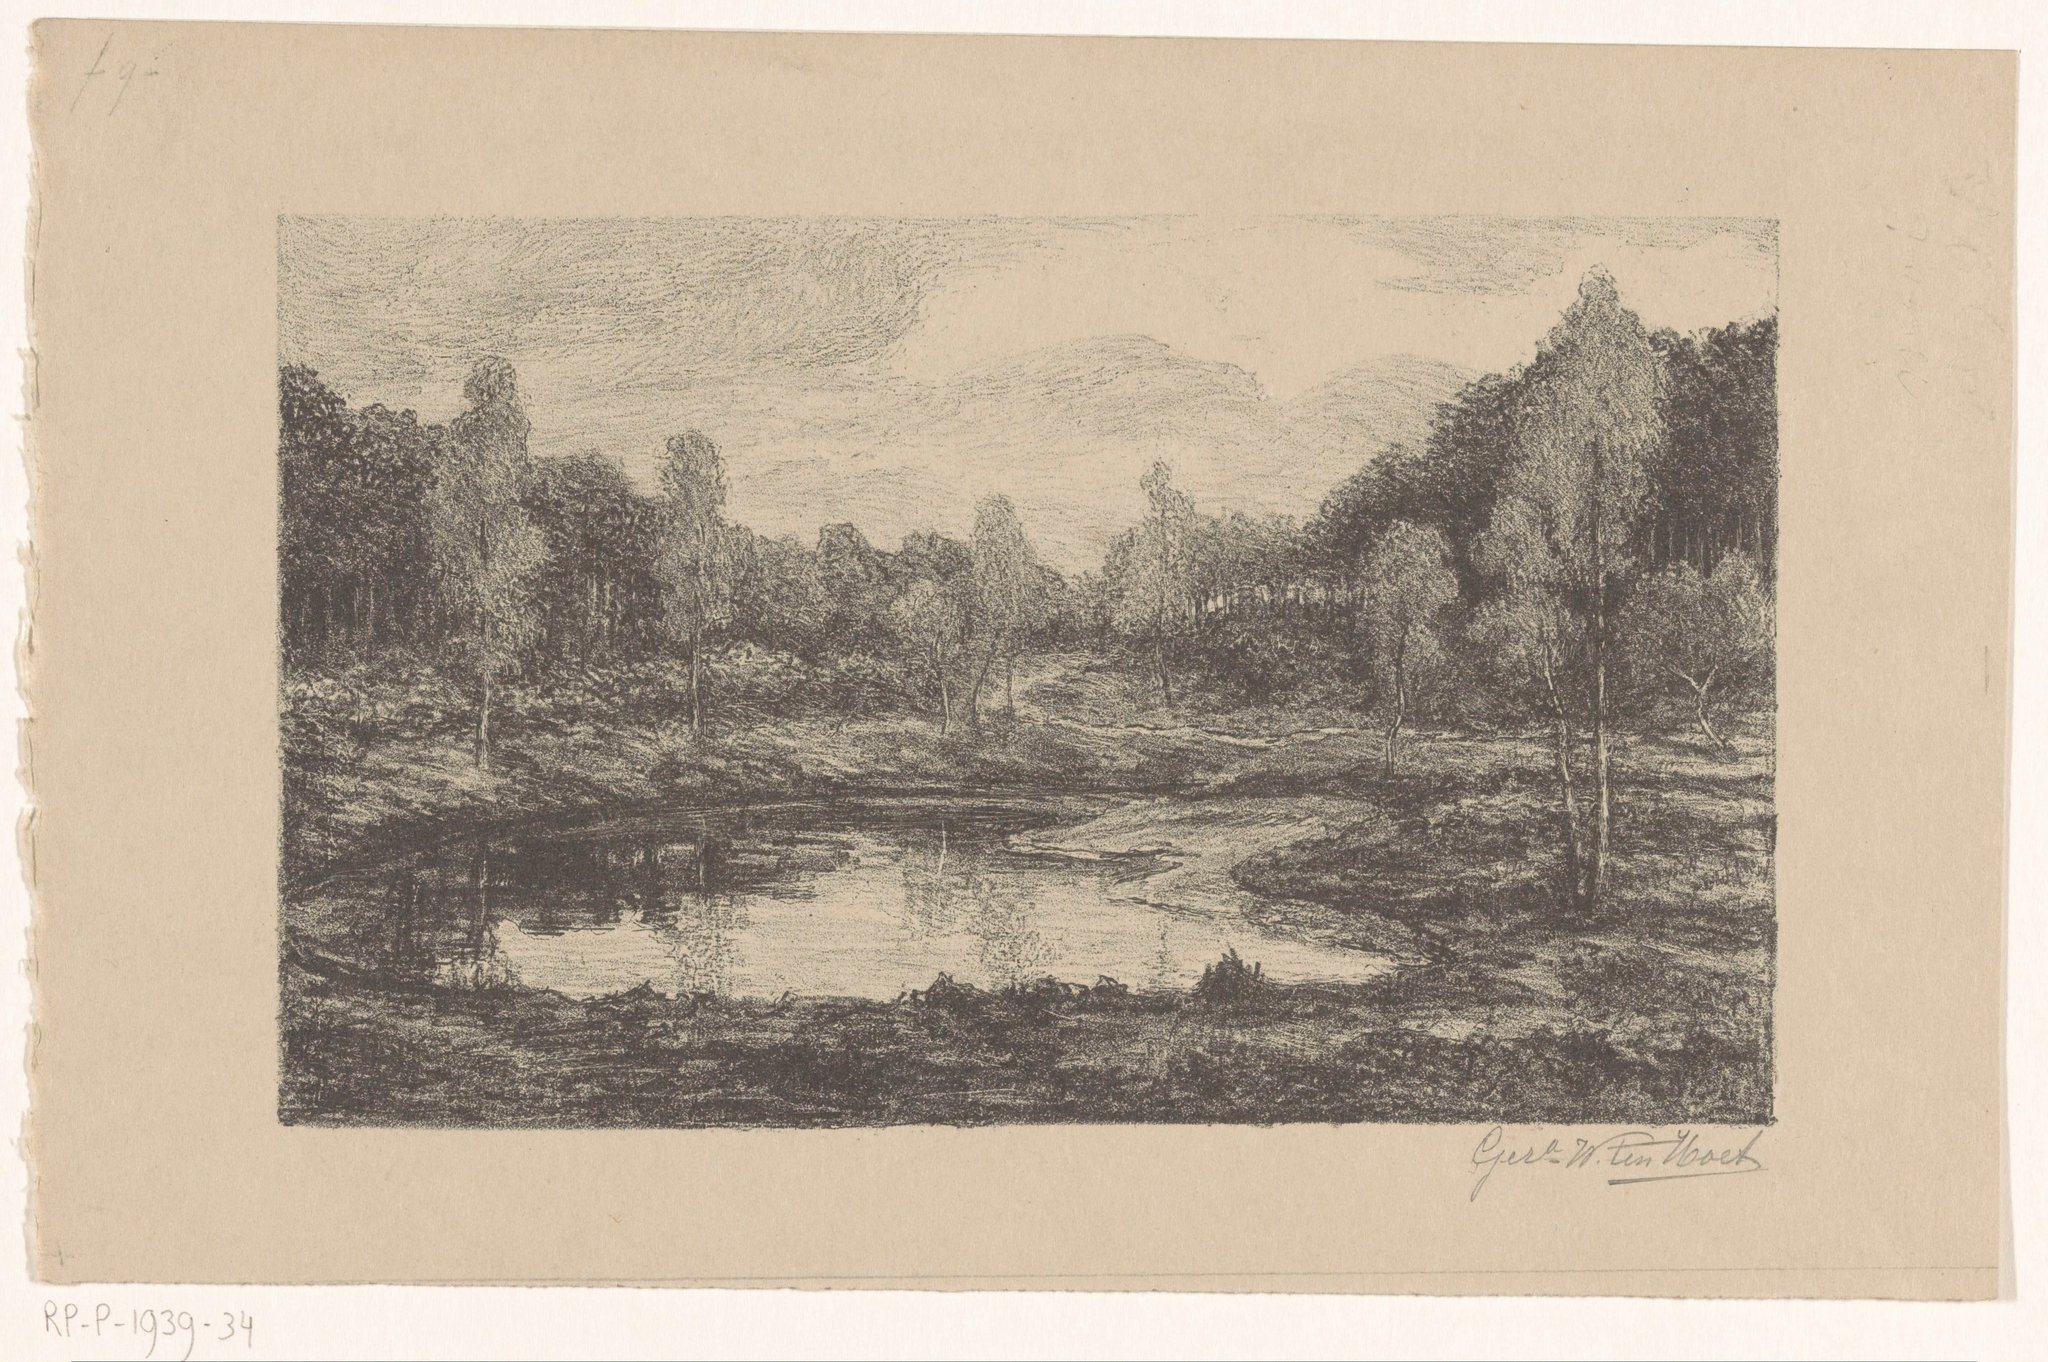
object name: print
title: Boschmeer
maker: gerarda wilhelmina ten hoet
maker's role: print maker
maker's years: 1857-1939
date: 1867-1939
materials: paper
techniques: lithograph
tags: fen, du. 'ven'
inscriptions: collector's mark: Lugt 2228